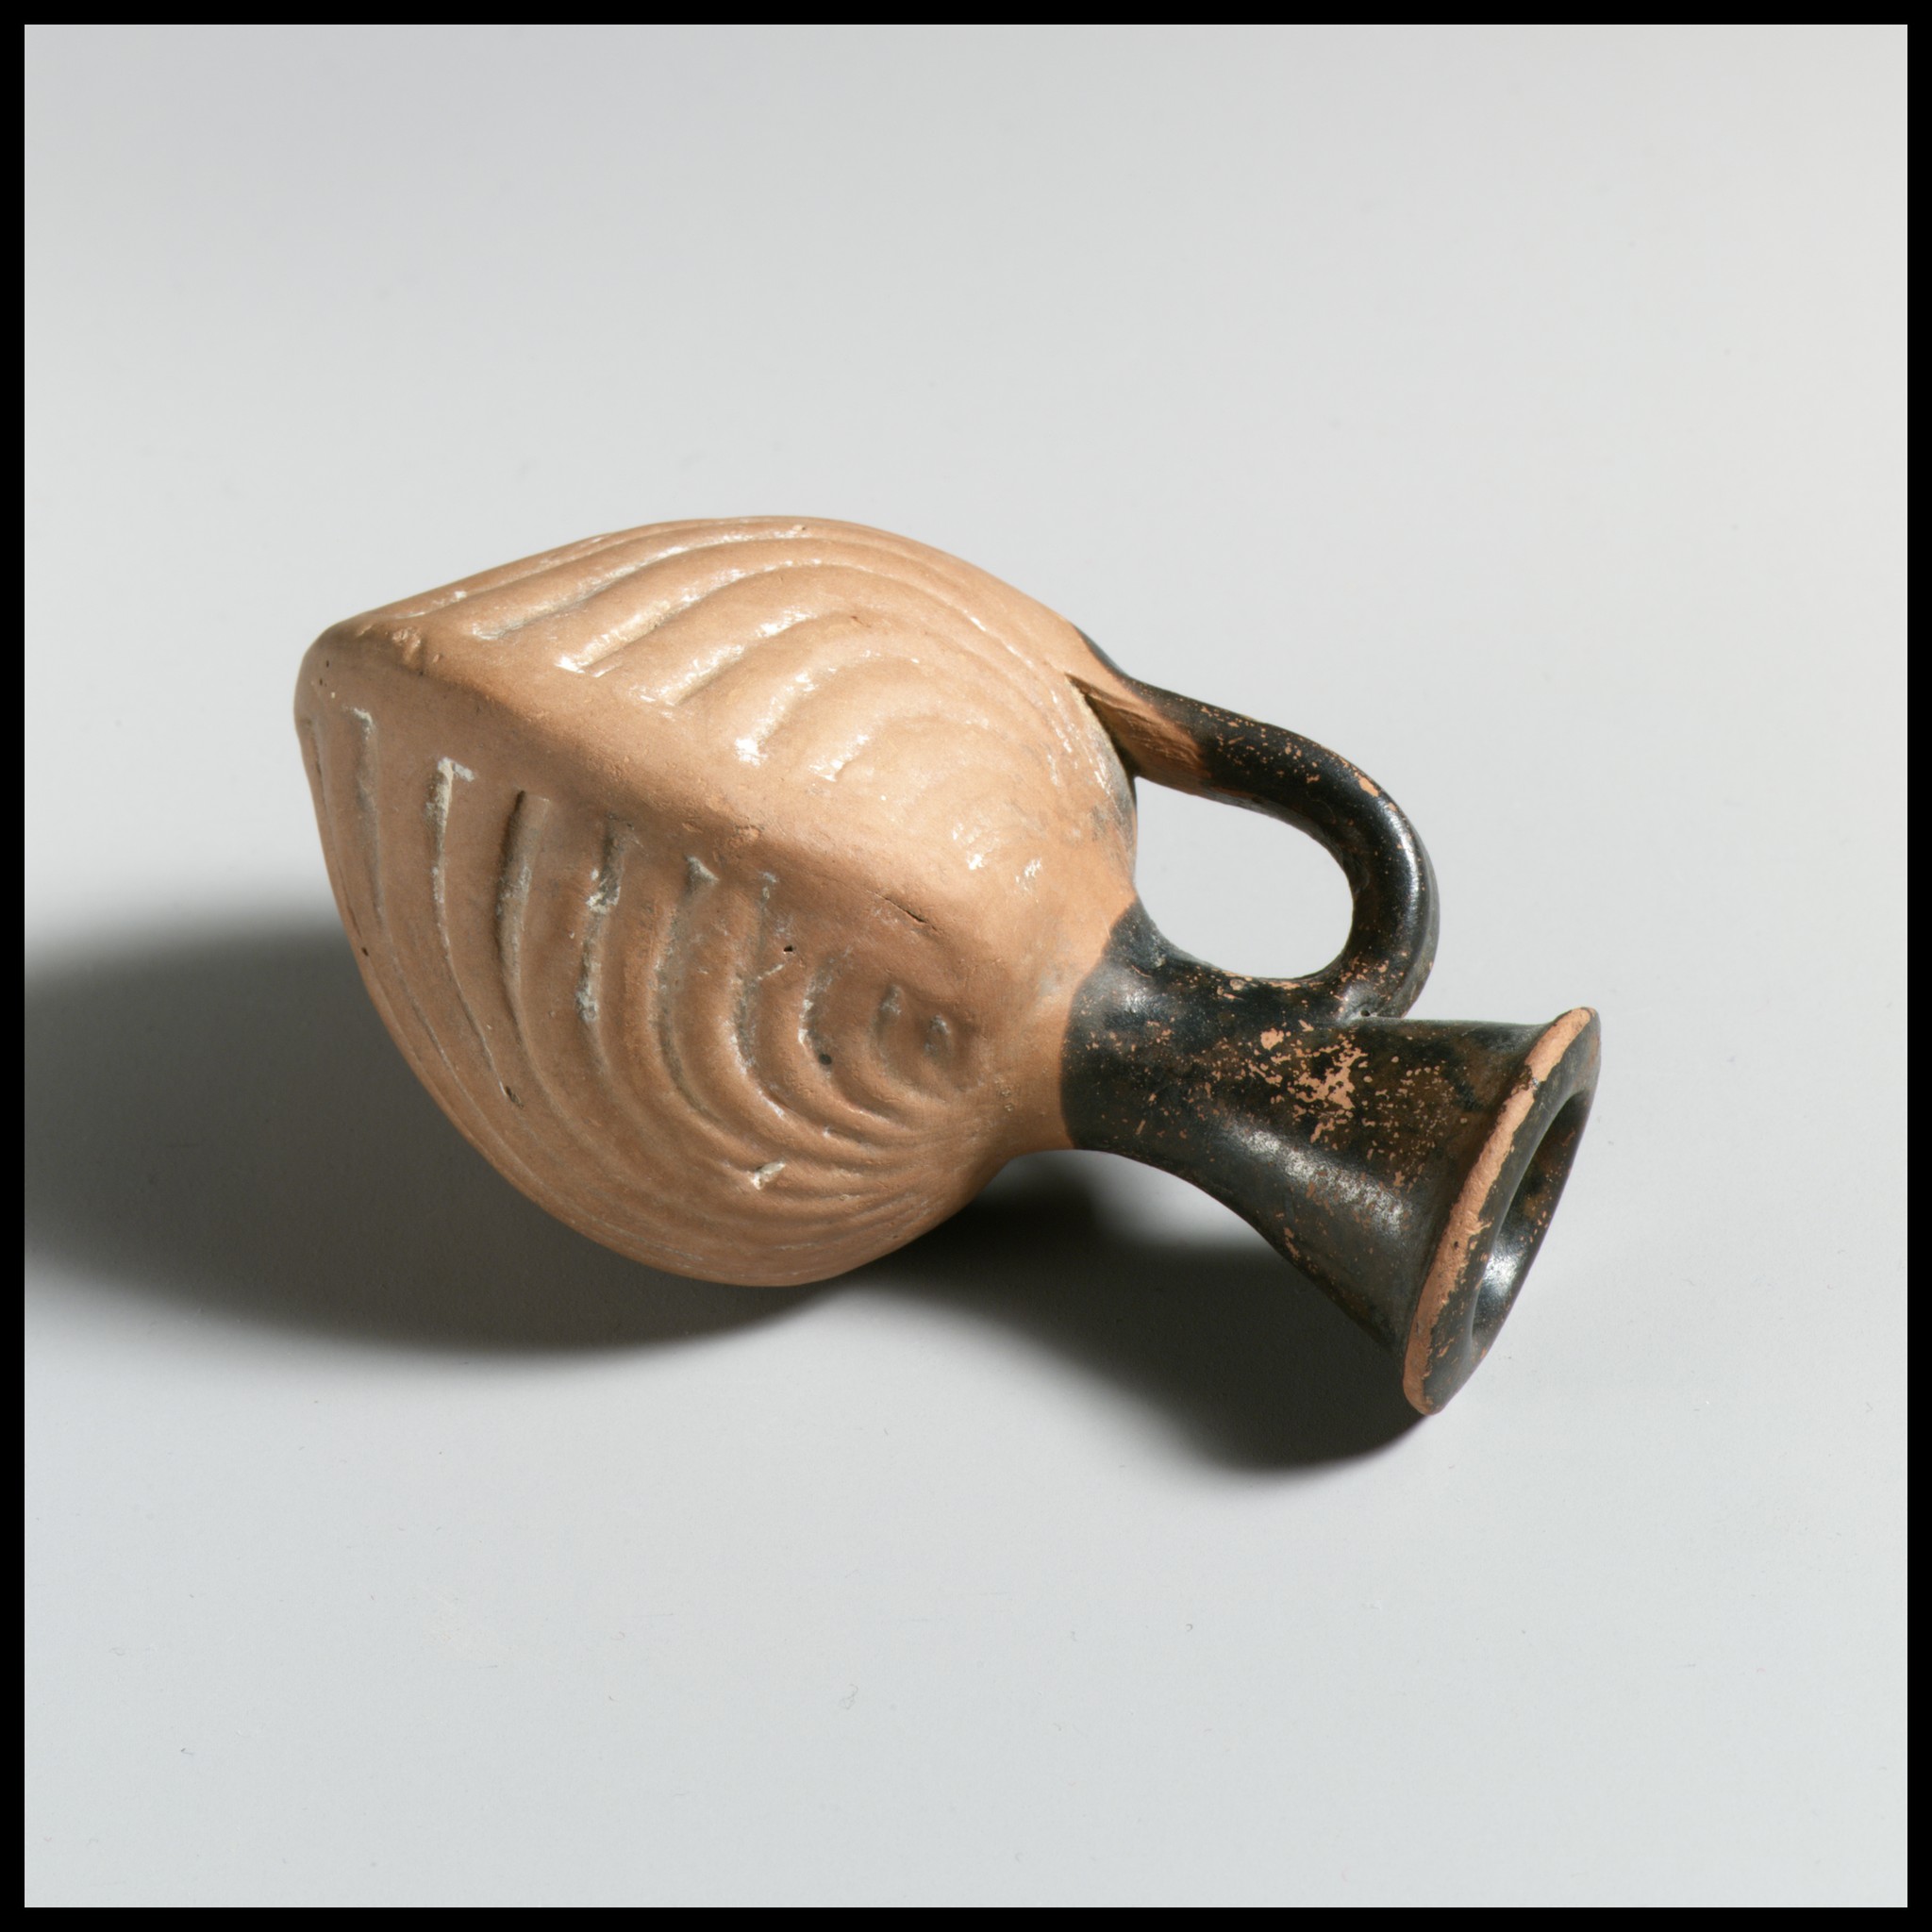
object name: vase in the form of two cockle shell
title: Terracotta vase in the form of two cockle shells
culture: greek, attic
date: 400-301 BCE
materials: terracotta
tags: shells